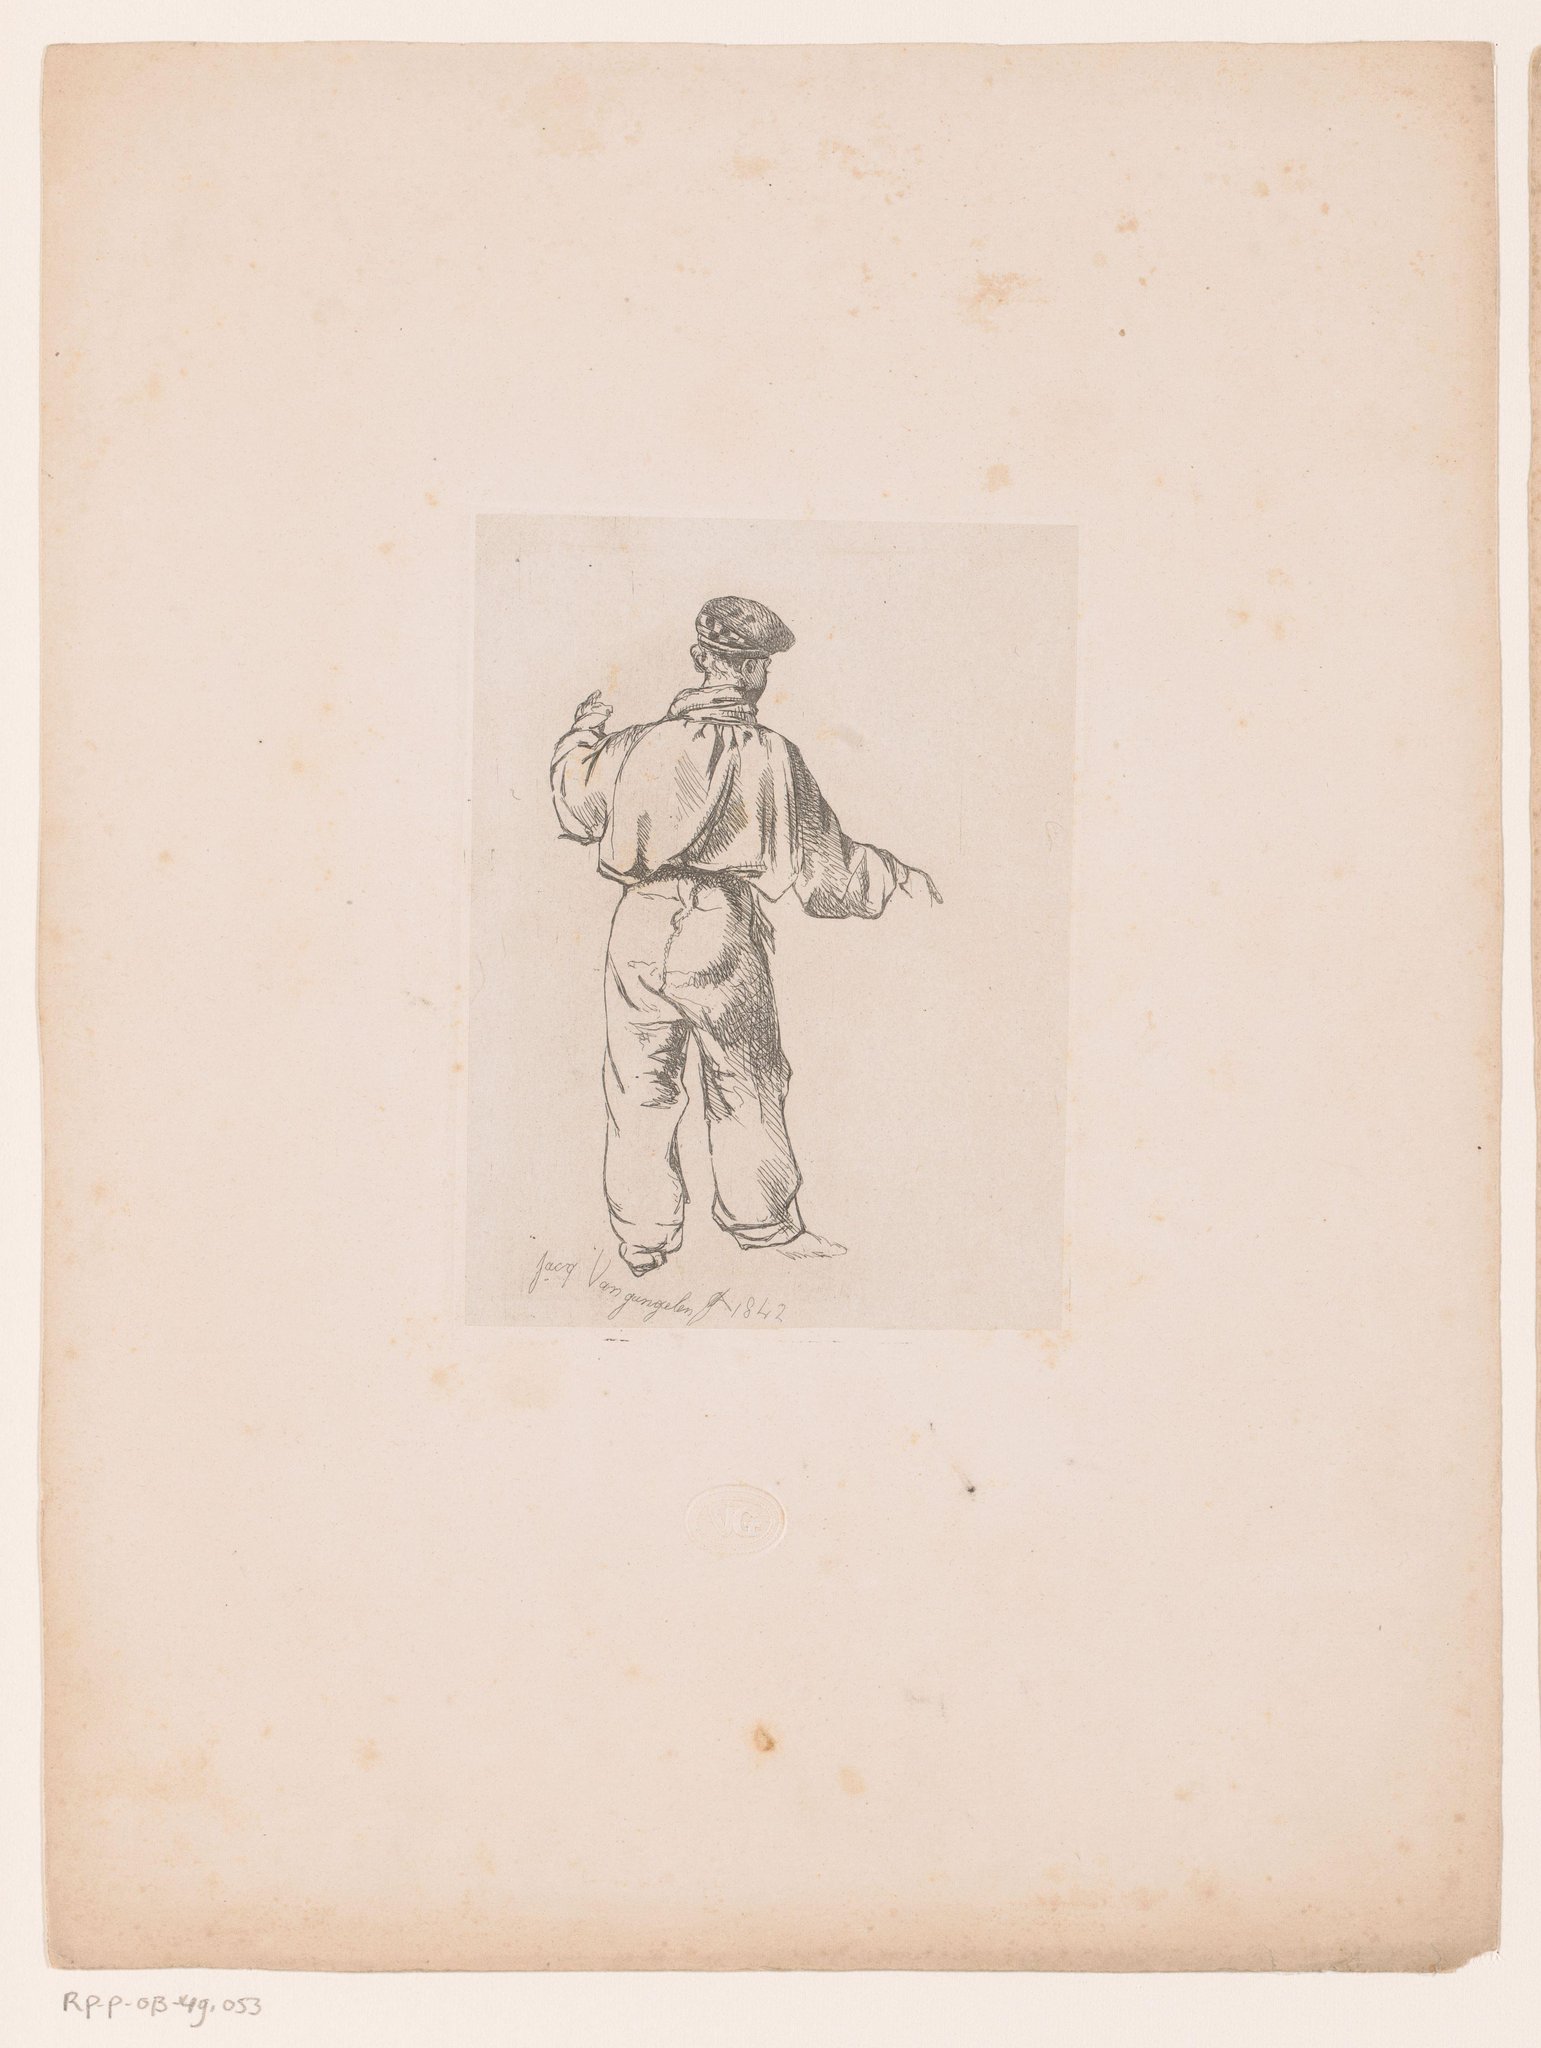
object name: print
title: Jongen op de rug gezien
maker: jacques van gingelen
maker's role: print maker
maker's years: 1801-1864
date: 1842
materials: paper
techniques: etching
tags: youth, adolescent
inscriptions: mark: ‘JVG’, collector's mark: Lugt 2228